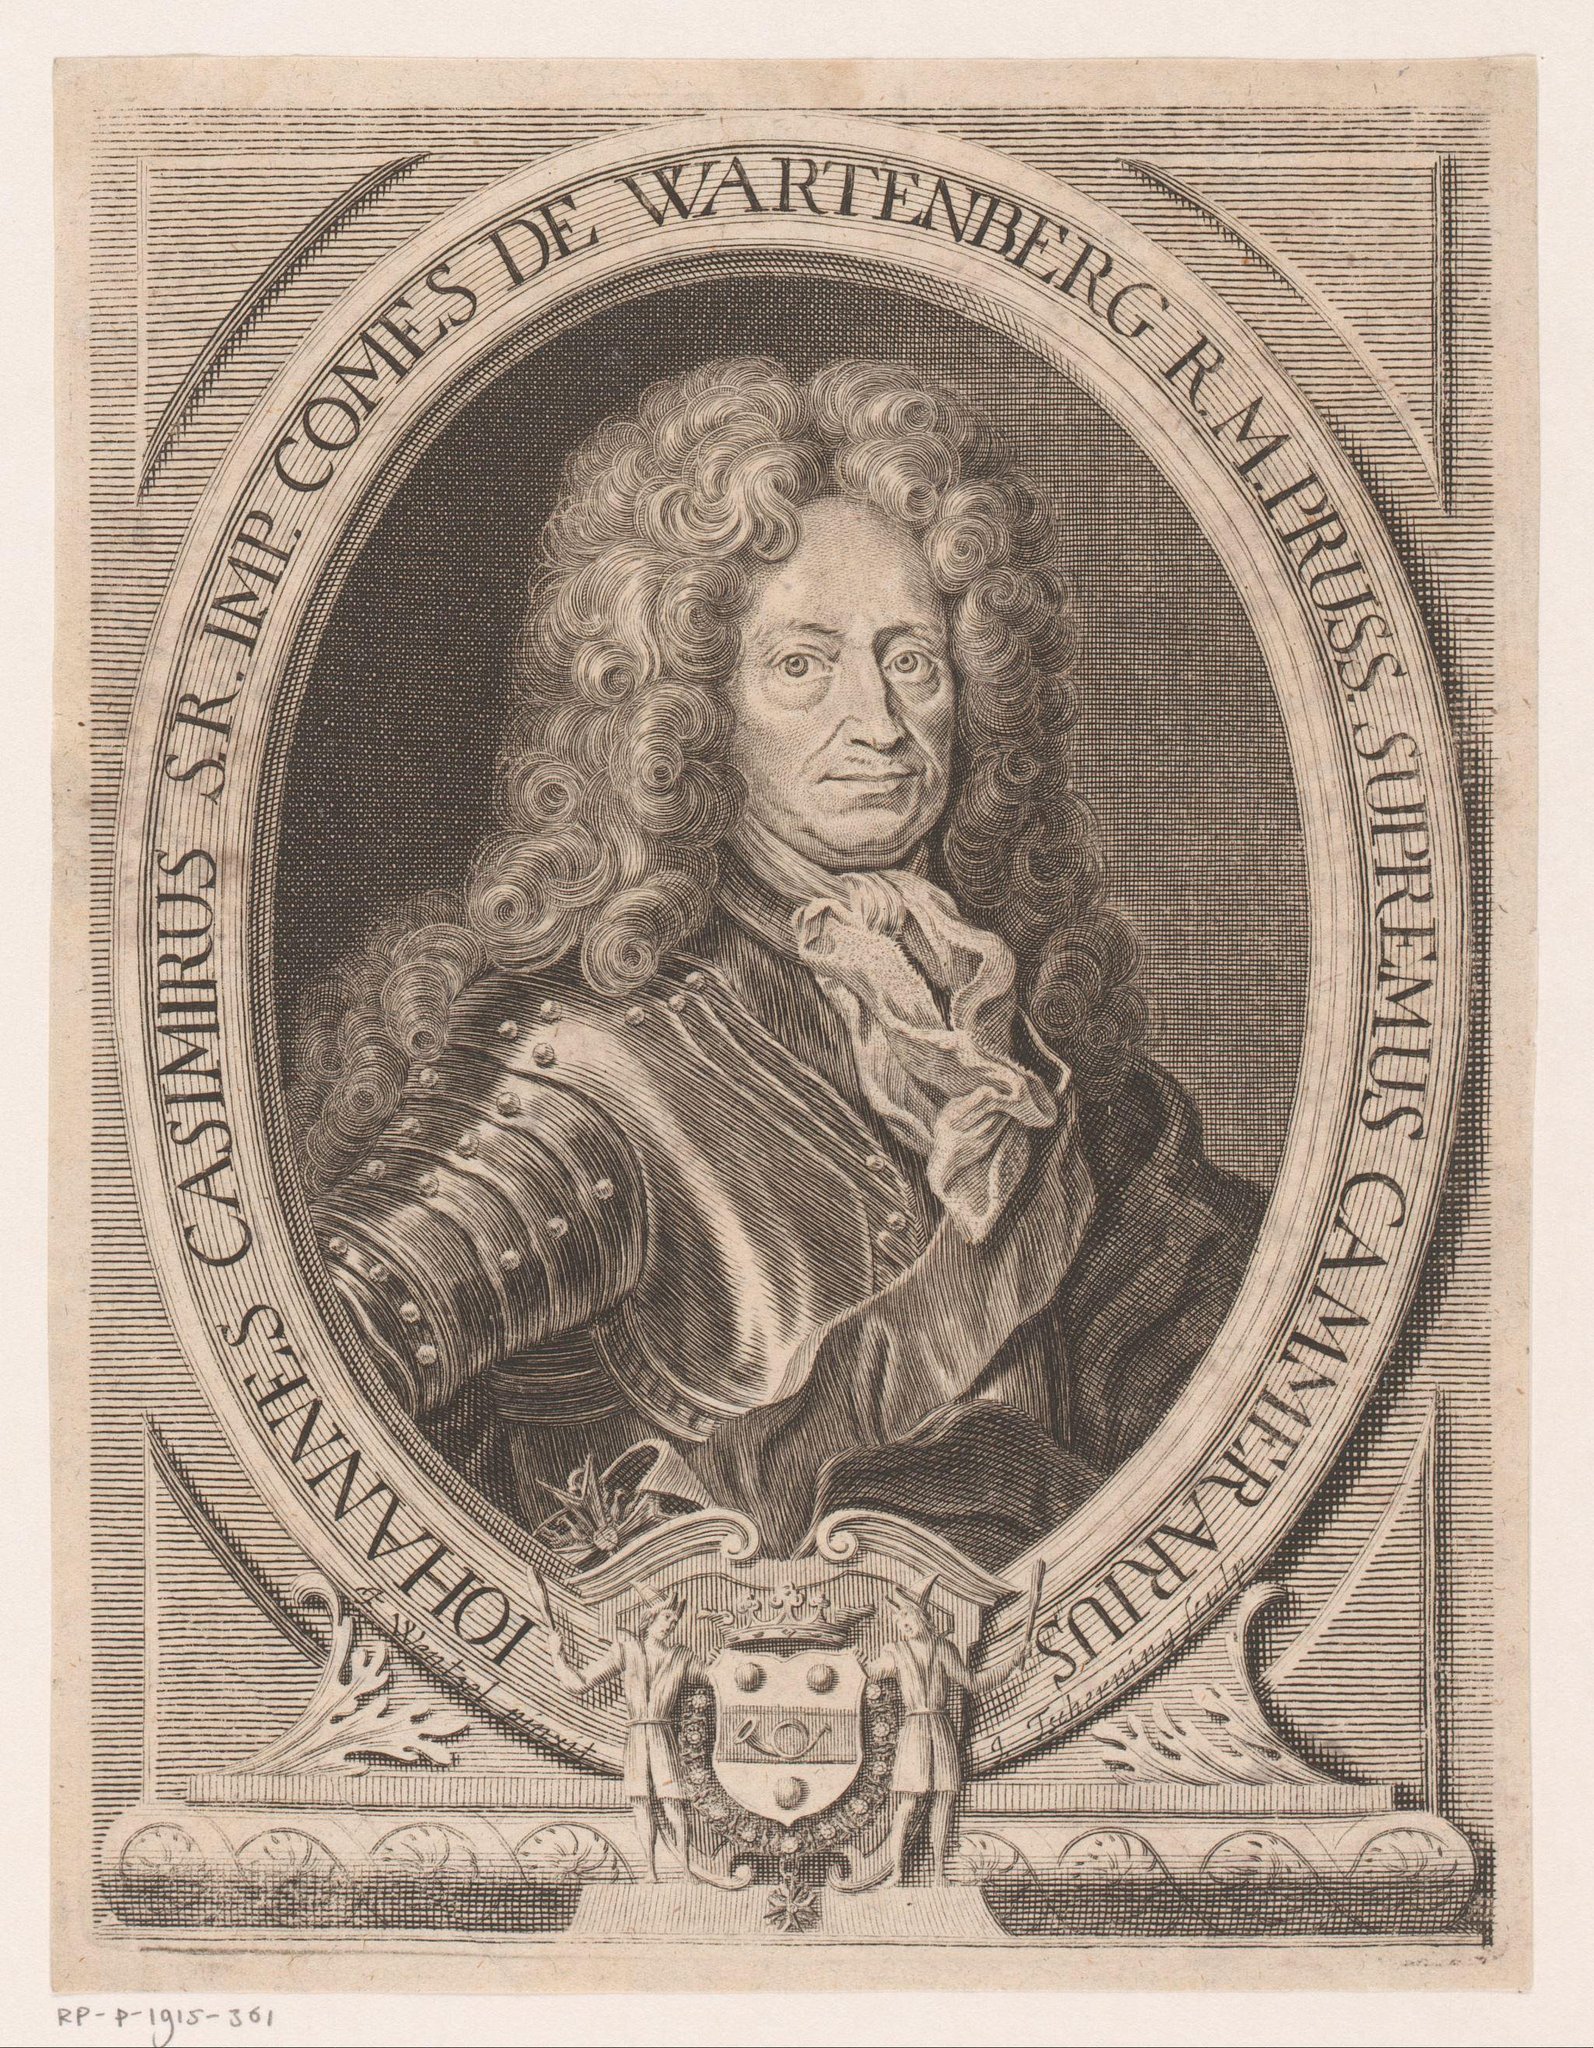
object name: print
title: Portret van Johann Casimir Kolbe van Wartenberg II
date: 1694-1729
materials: paper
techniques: engraving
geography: germany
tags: armour, historical persons, armorial bearing, heraldry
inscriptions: collector's mark: Lugt 2228